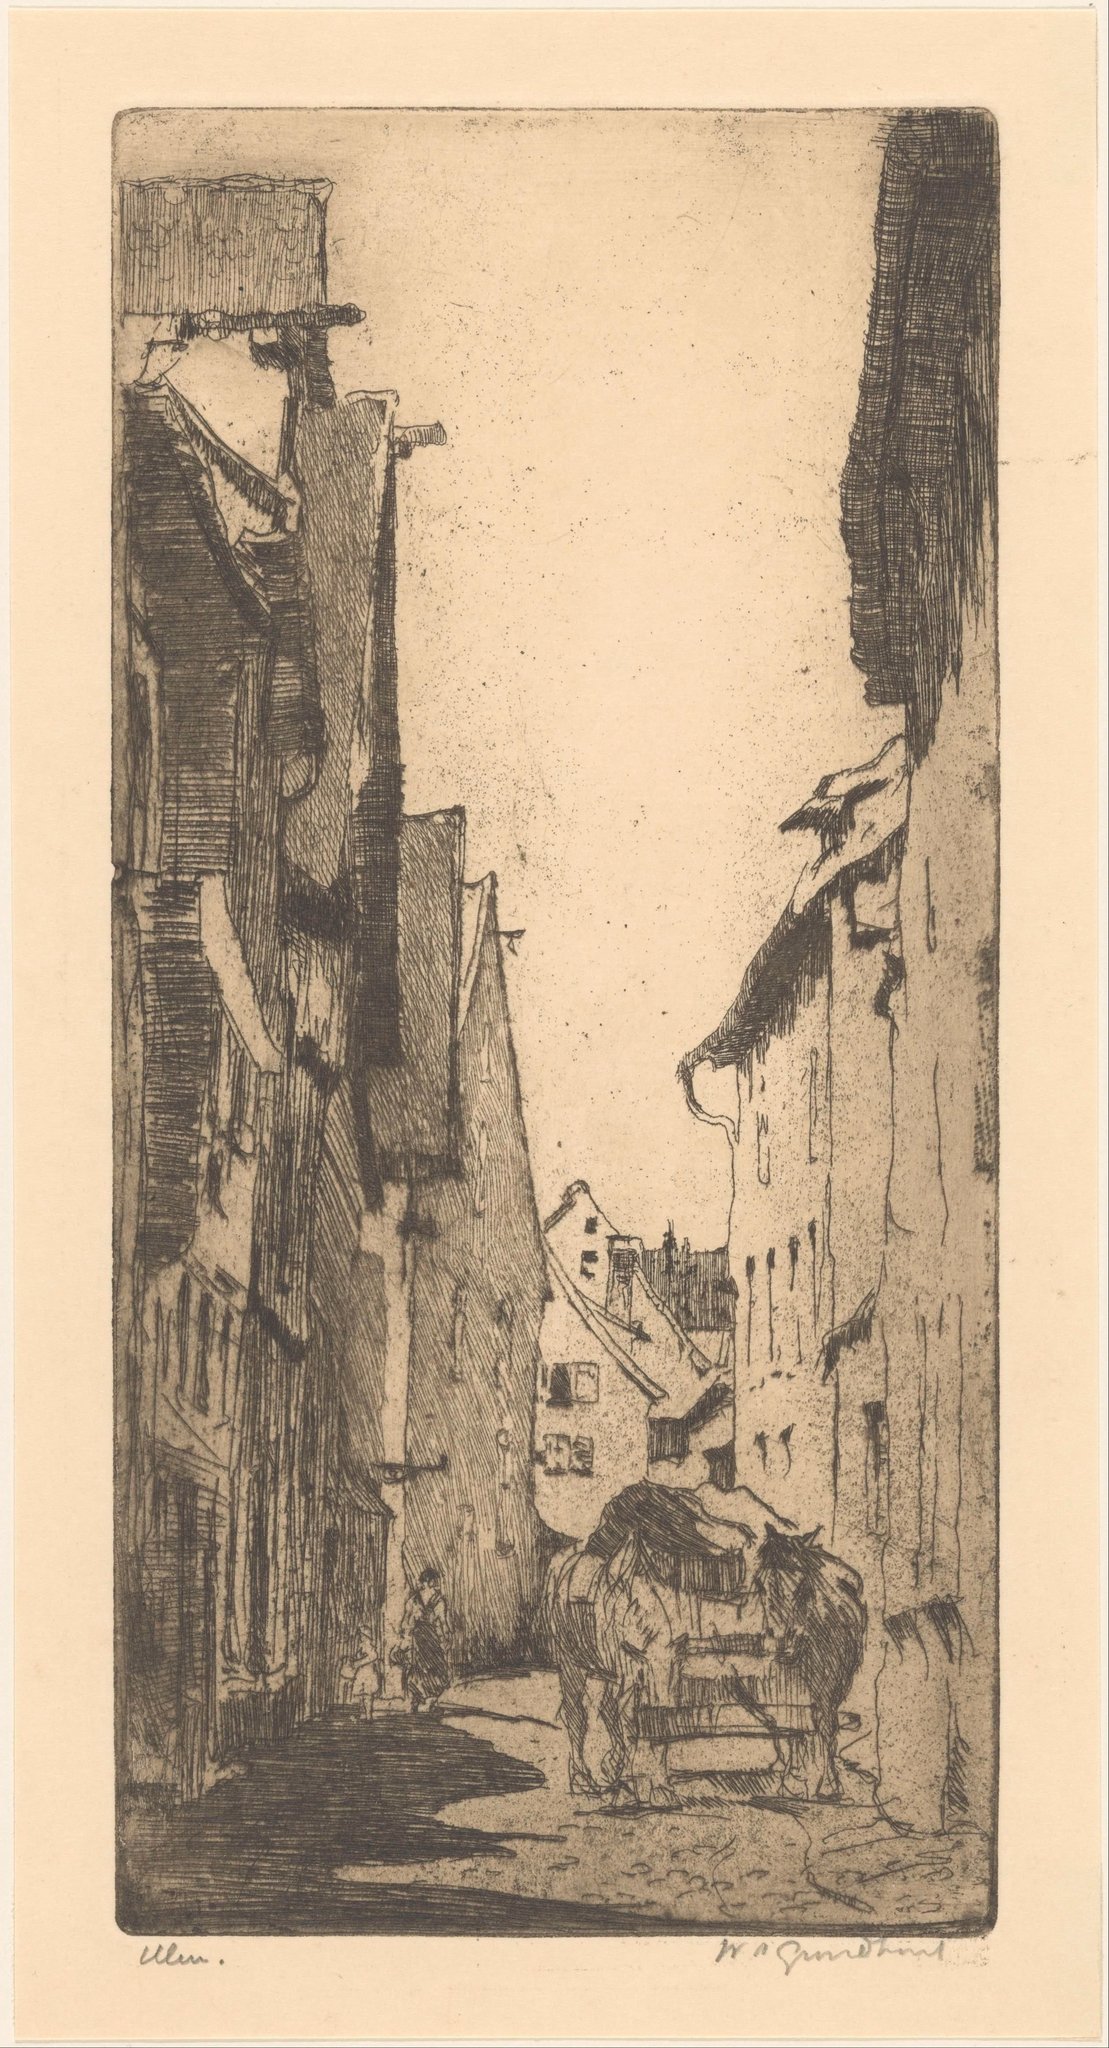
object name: print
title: Ulm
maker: willem adrianus grondhout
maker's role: draughtsman, painter, print maker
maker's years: 1878-1934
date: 1888-1931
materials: paper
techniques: etching, intaglio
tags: animal traction, animal-drawn vehicle (carriage etc.), street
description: Een straat in het Duitse Ulm met een paardenkar.